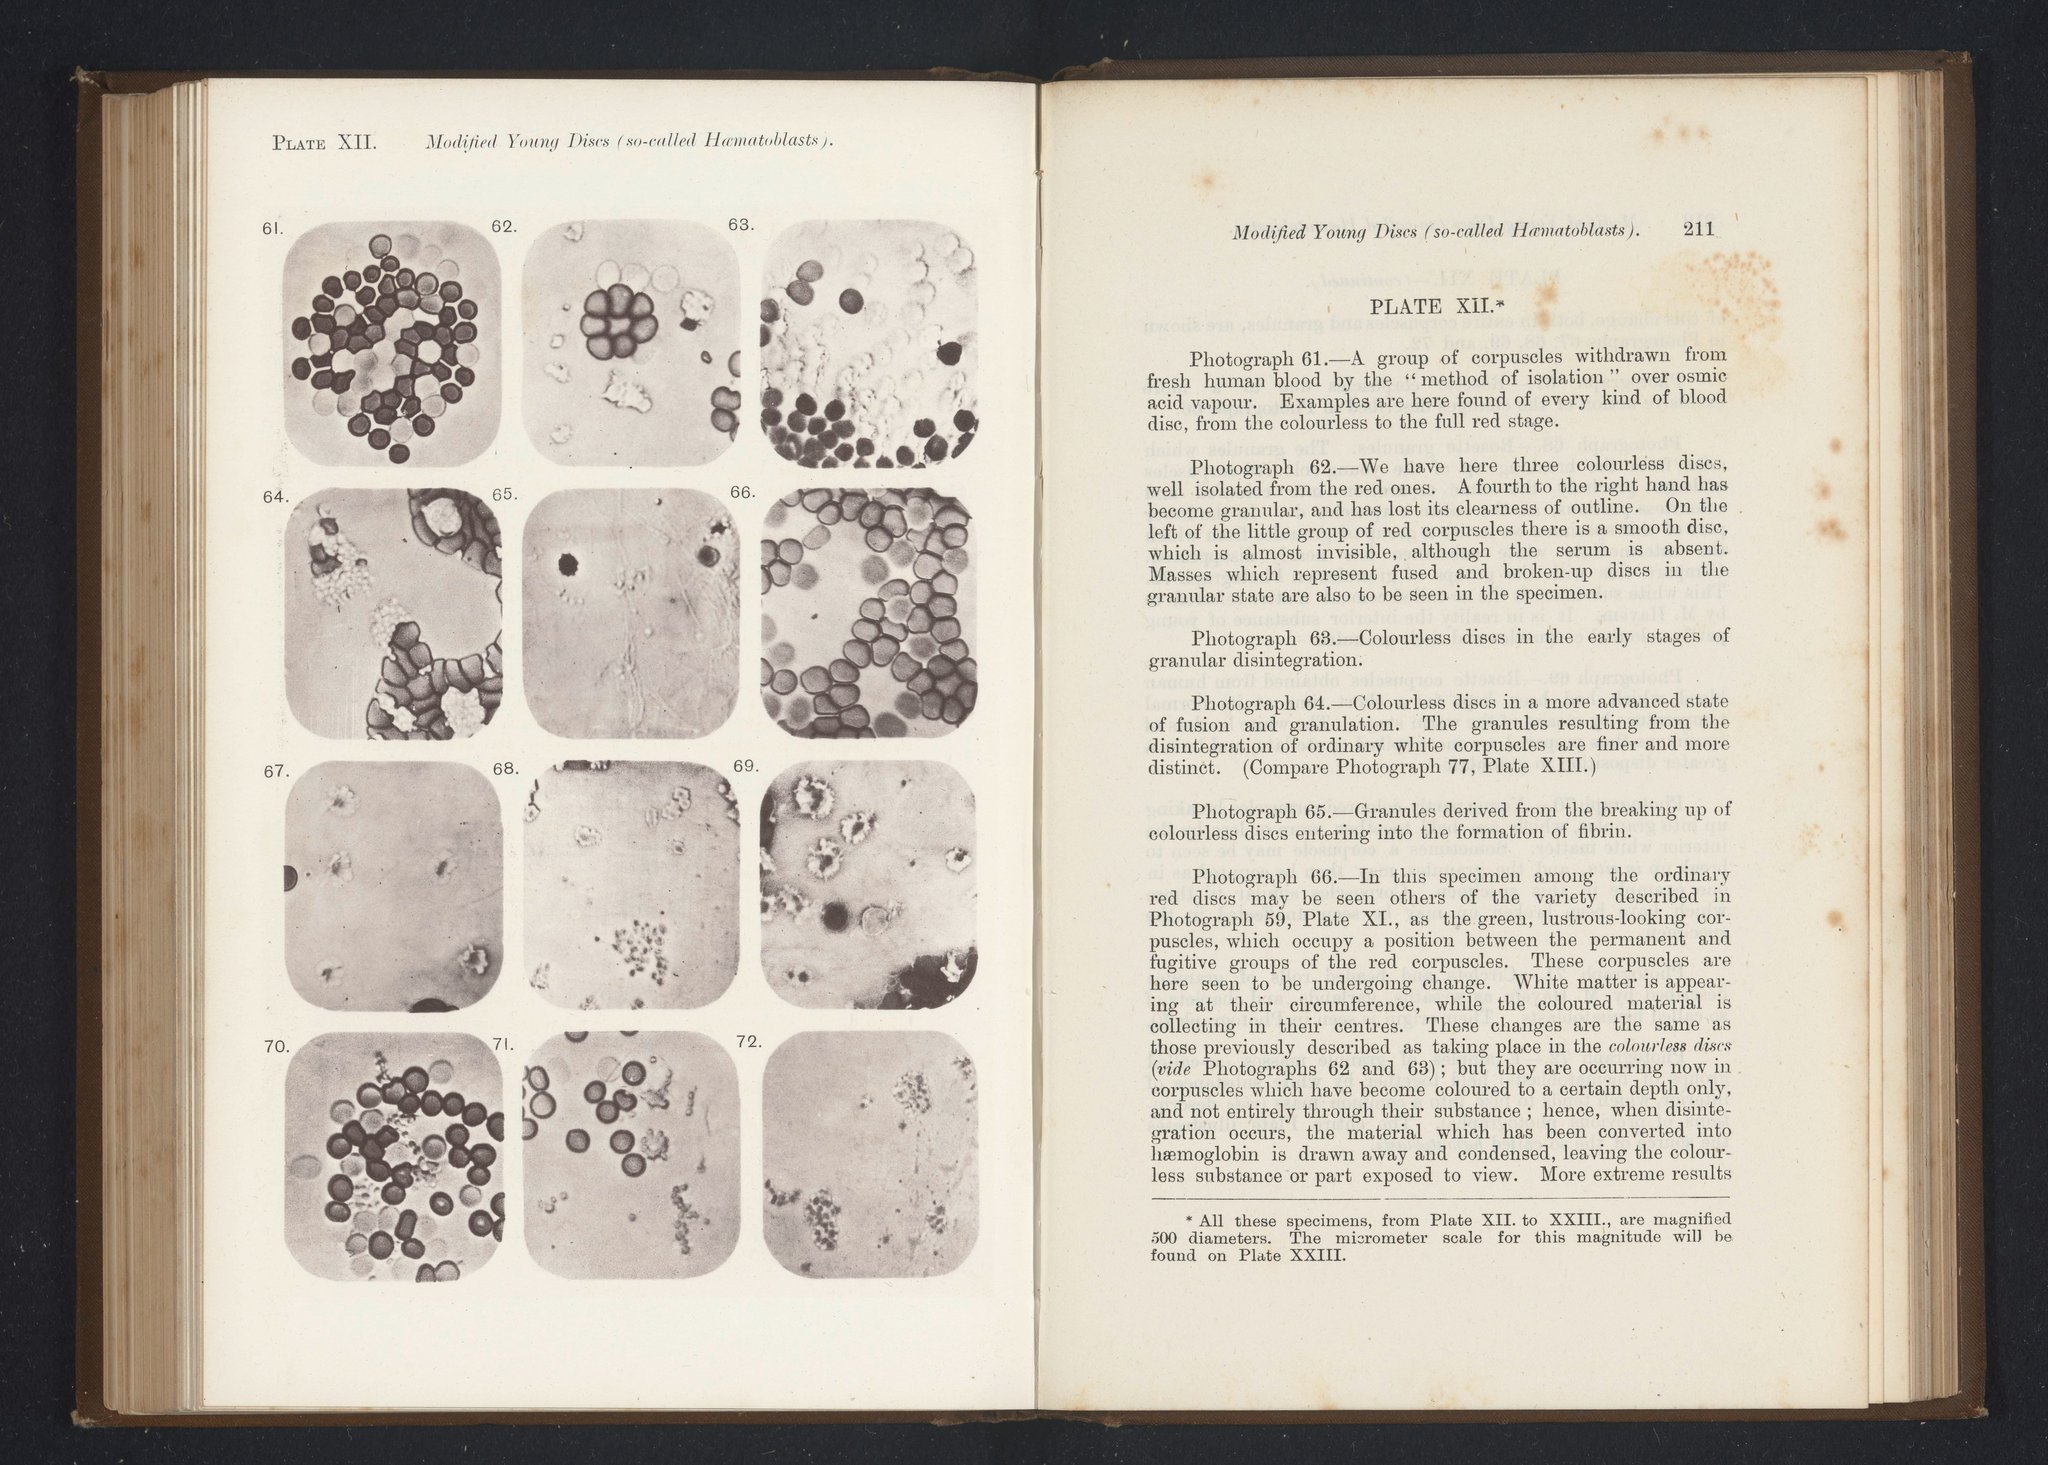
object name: photomechanical print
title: Twaalf vergrotingen van bloedlichaampjes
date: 1872-1882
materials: paper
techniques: photograph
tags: blood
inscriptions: number: ‘Pl. XII.’, number: ‘Photo. 61. (...) Photo. 72.’